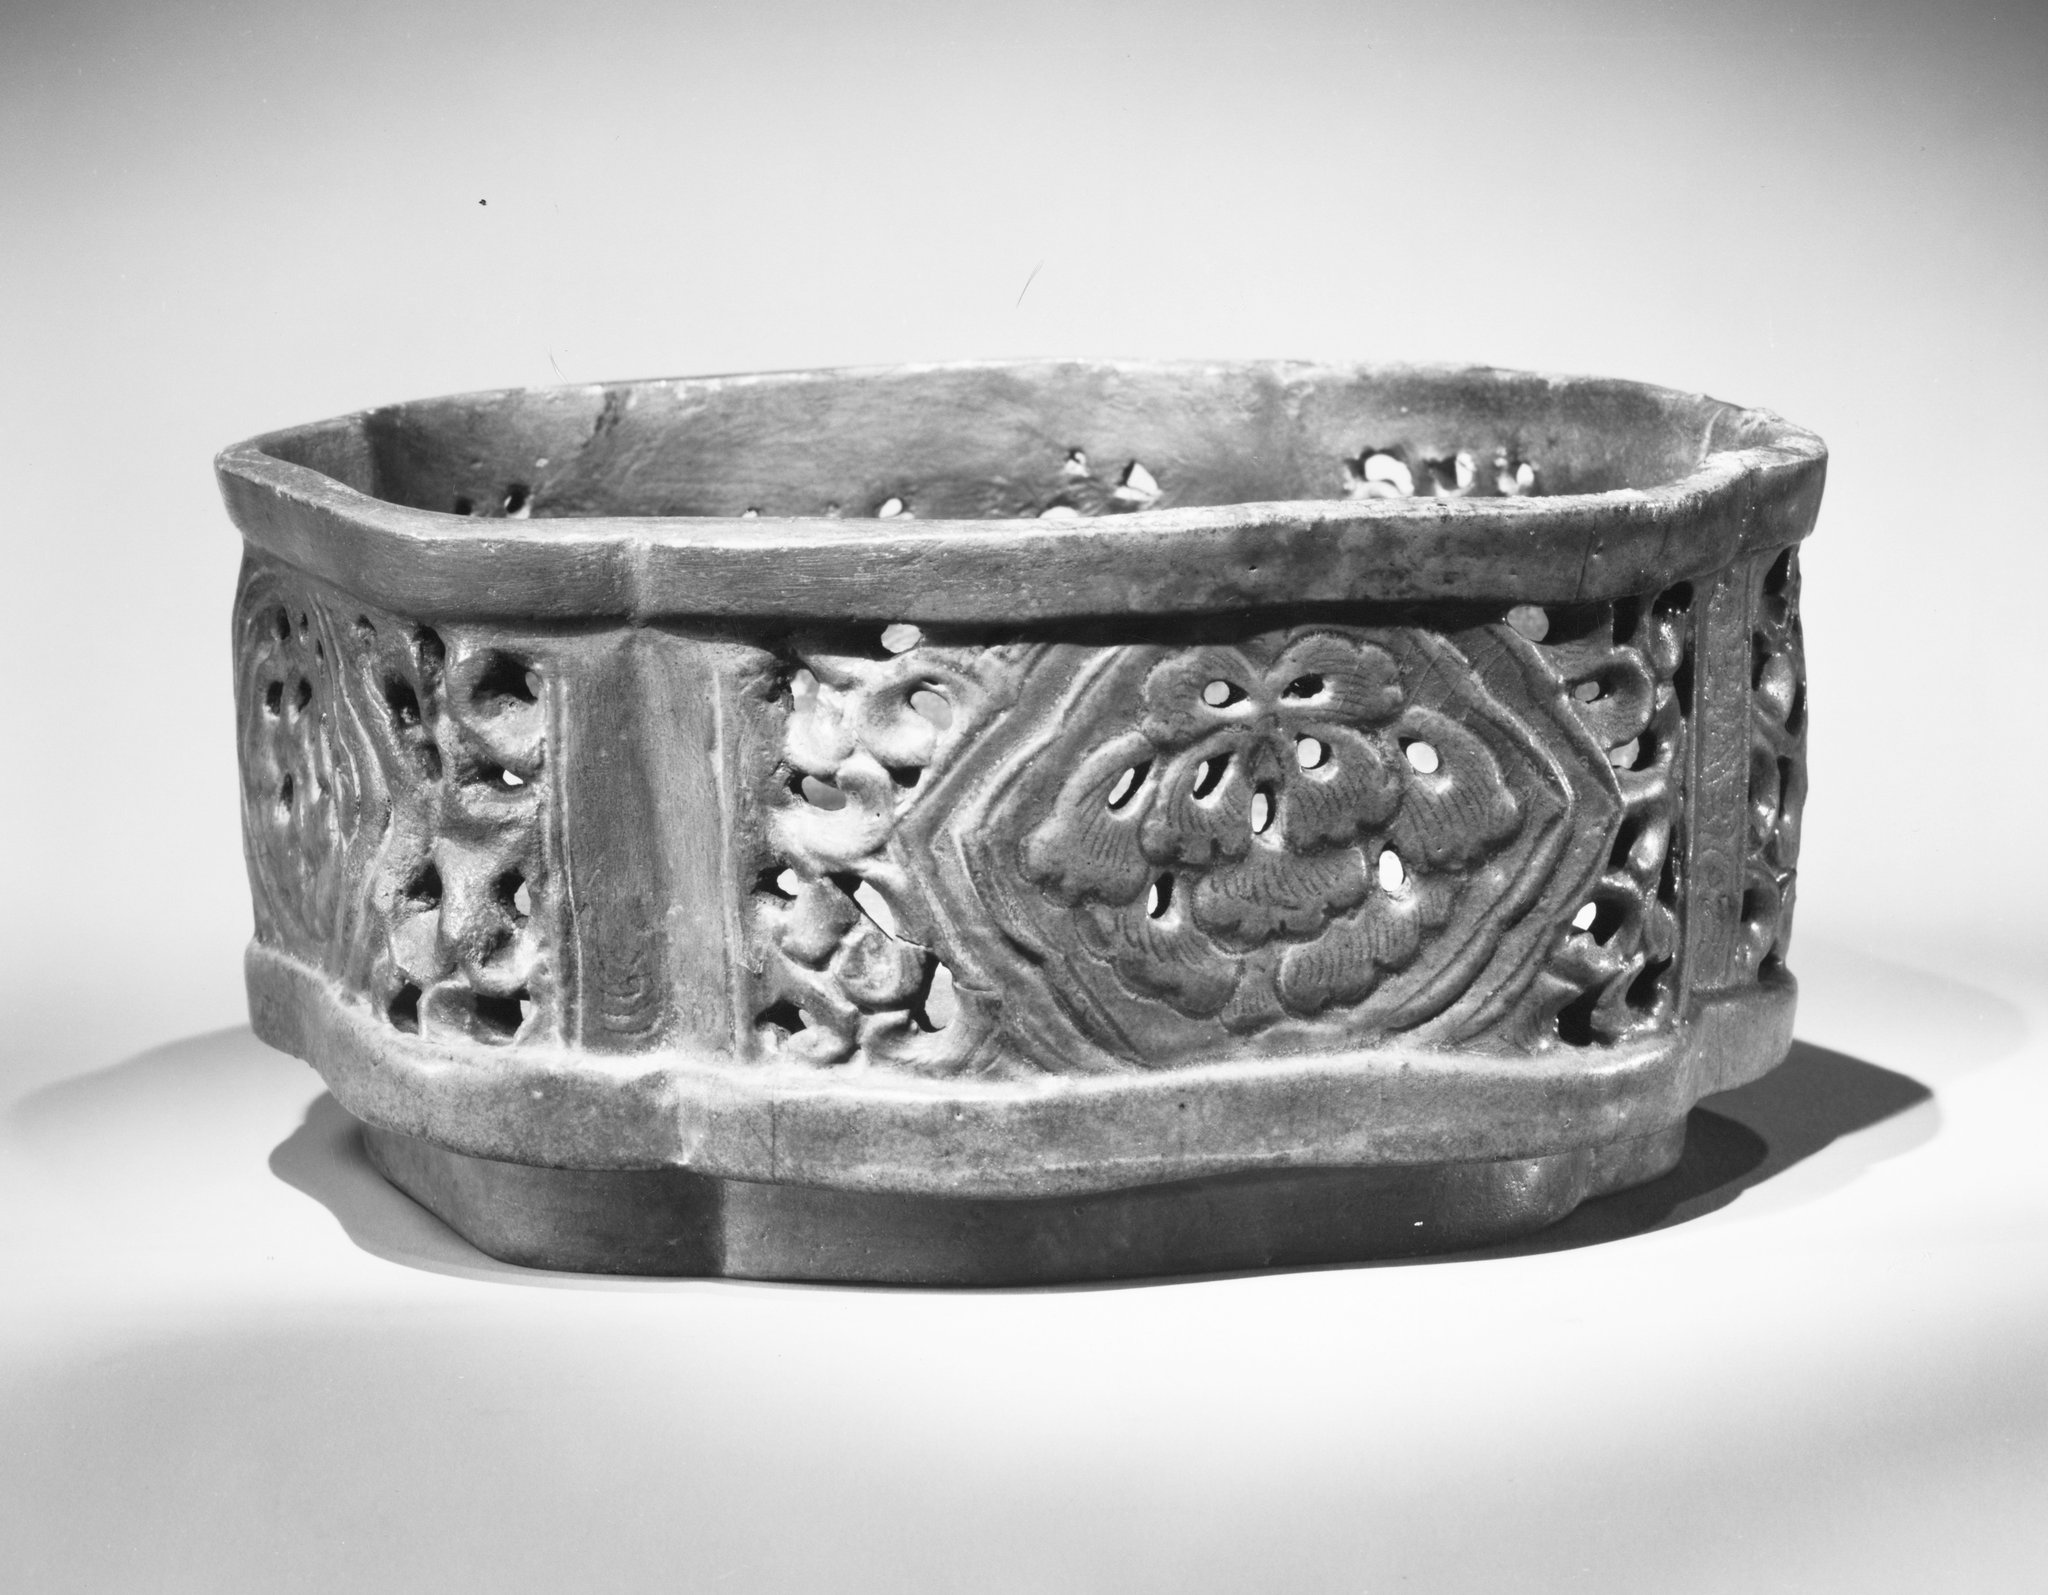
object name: brush washer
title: Brush Washer (Yüe ware)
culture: chinese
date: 618-907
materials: pottery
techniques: glazing